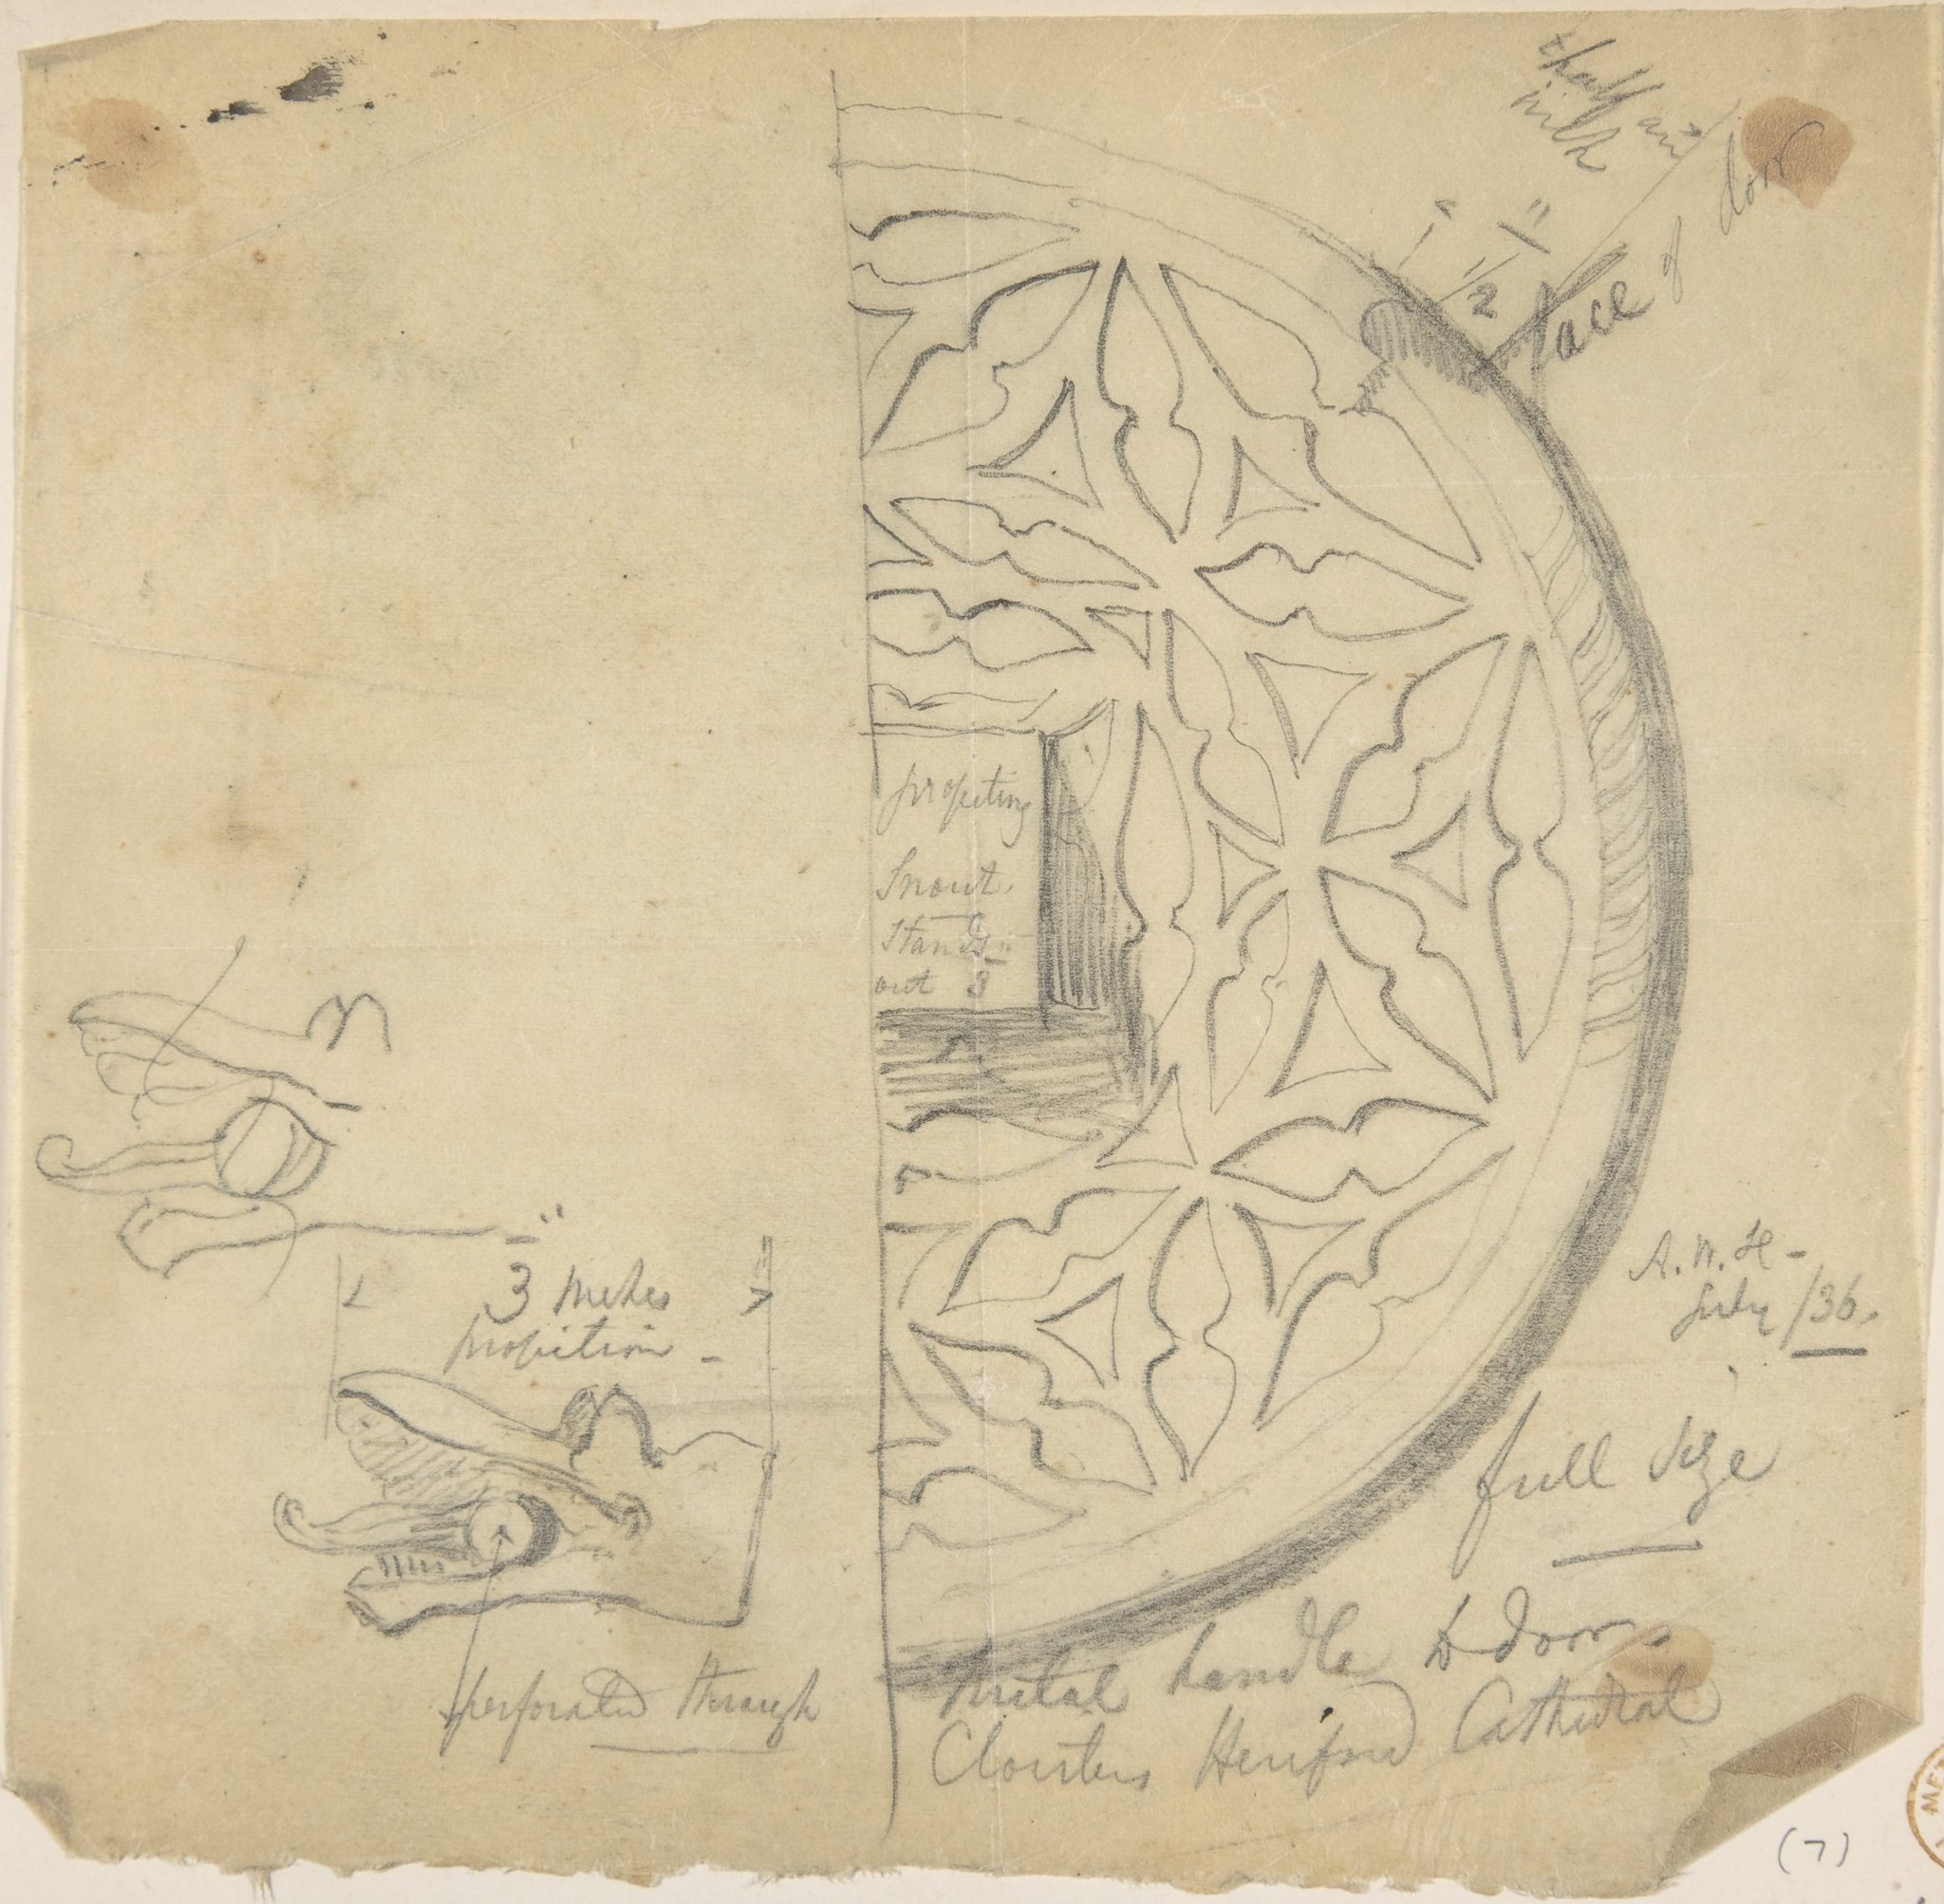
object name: drawing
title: Metal Doorhandle, Cloisters, Hereford Cathedral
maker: richardson ellson & co.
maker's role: artist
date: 1880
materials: graphite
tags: ornament